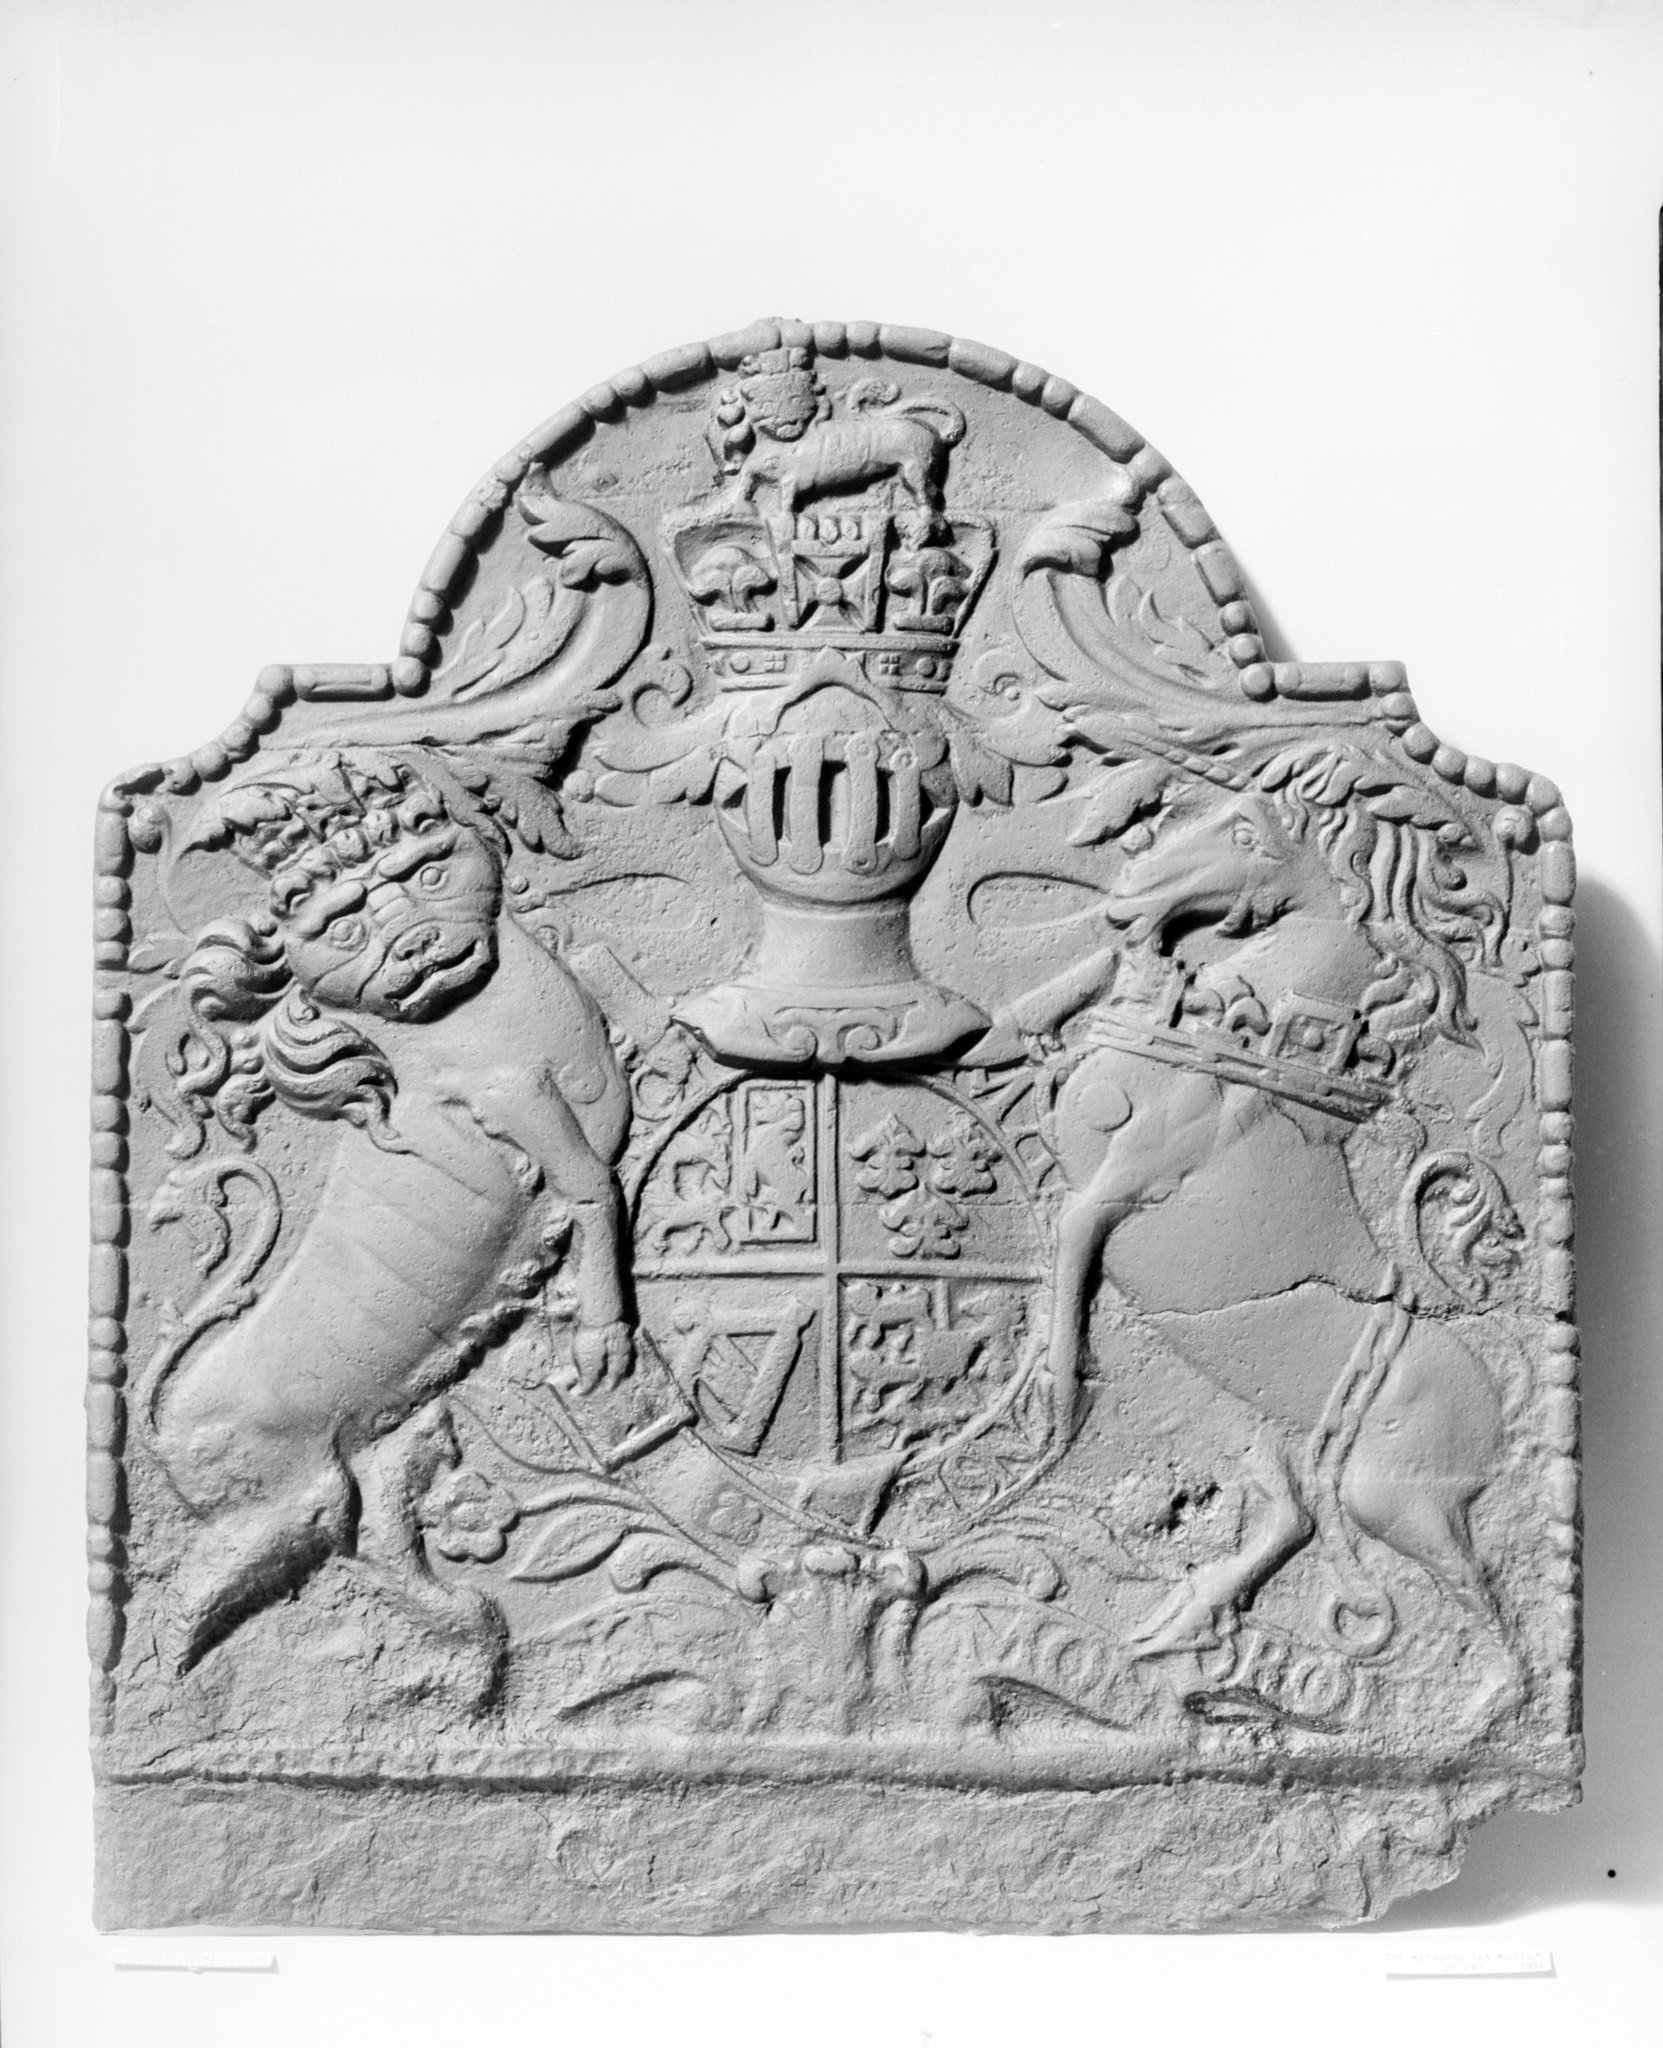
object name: fireback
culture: american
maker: oxford furnace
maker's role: maker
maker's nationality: american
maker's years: 1743-1882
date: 1745-1758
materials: iron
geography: united states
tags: coat of arms